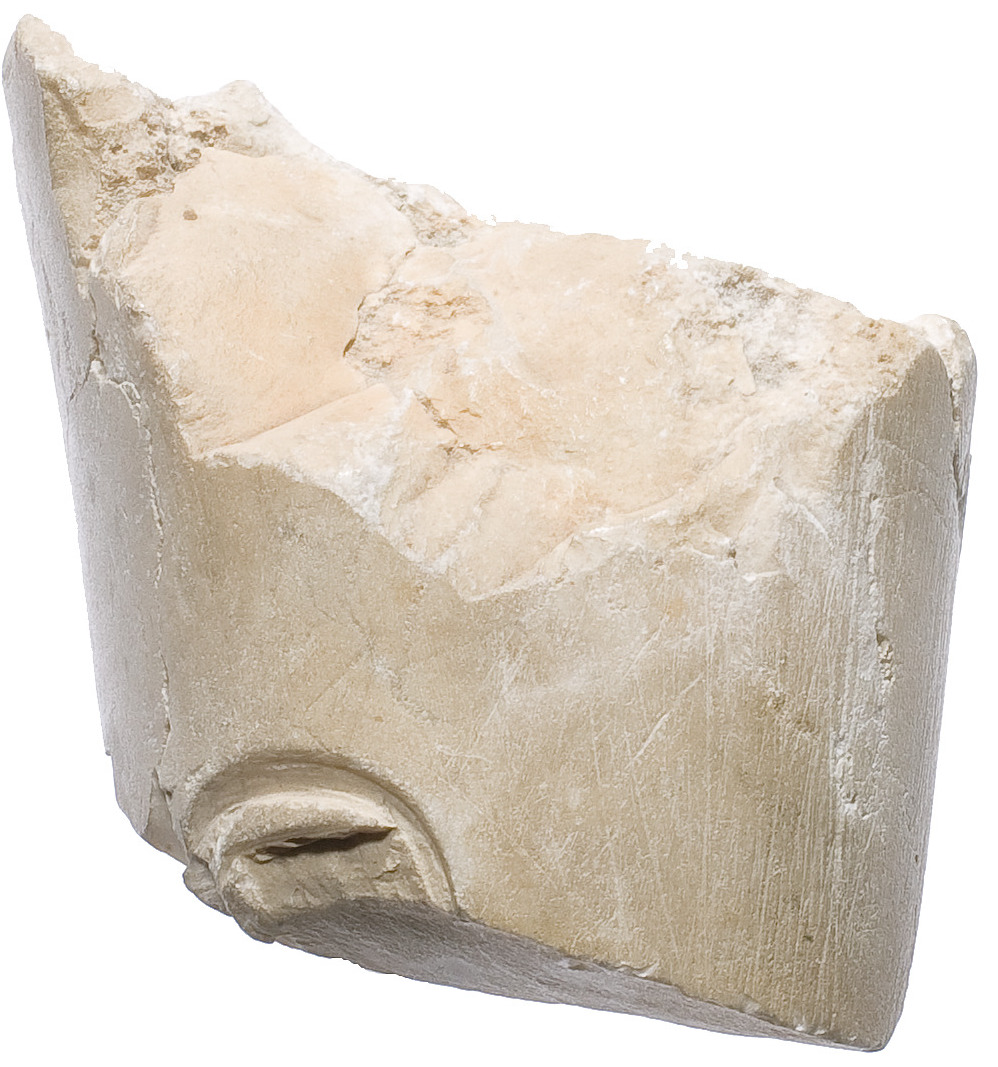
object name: arm, aten cartouch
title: Arm with Aten cartouche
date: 1353-1336 BCE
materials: limestone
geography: egypt